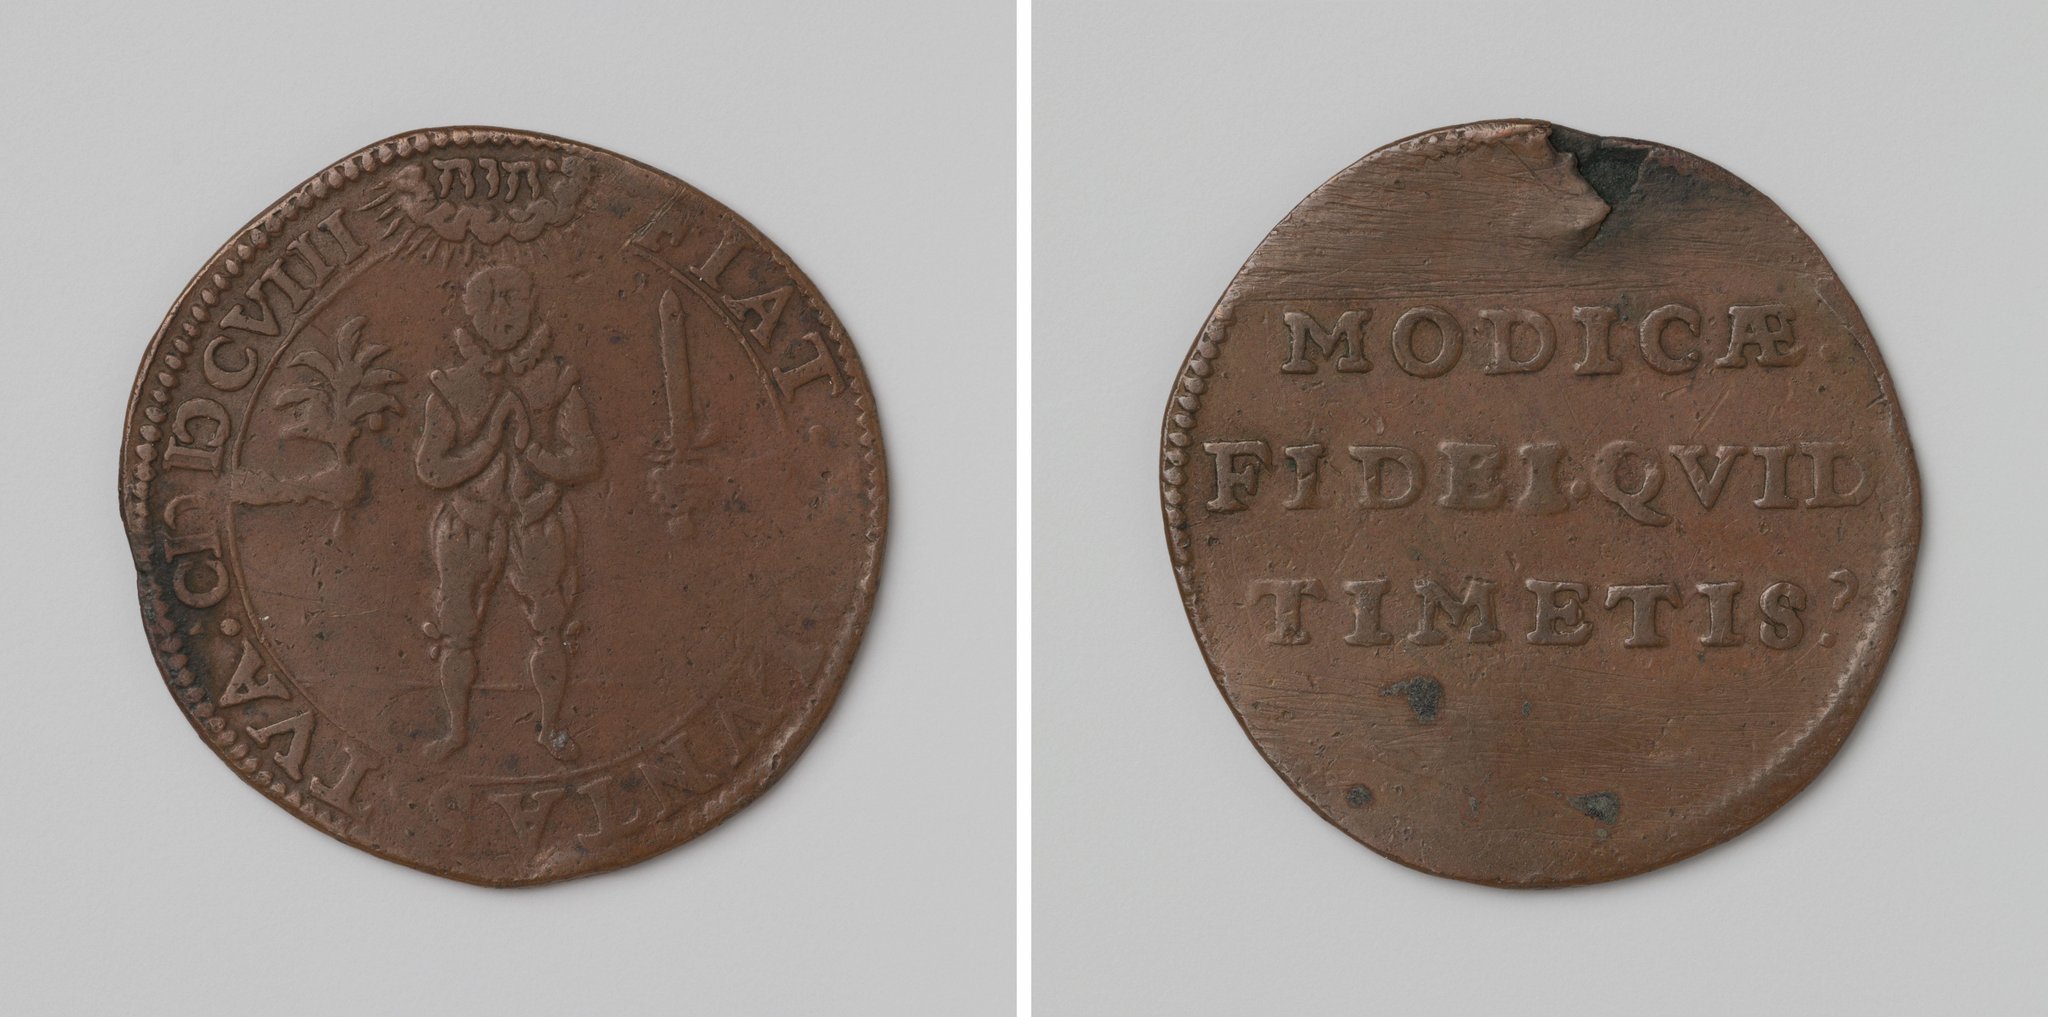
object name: jeton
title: Algemene gebedsdag bij de aanvang van de onderhandelingen te 's-Gravenhage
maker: Anonymous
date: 1608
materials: copper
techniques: striking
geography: dordrecht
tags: the hague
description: Koperen penning. Voorzijde: biddende man met gevouwen handen en blik omhoog gewend, waar naam Jehova in Hebreeuws in wolk geschreven staat; links hand die olijftak aanbiedt, rechts hand die zwaard toont binnen omschrift. Keerzijde: opschrift